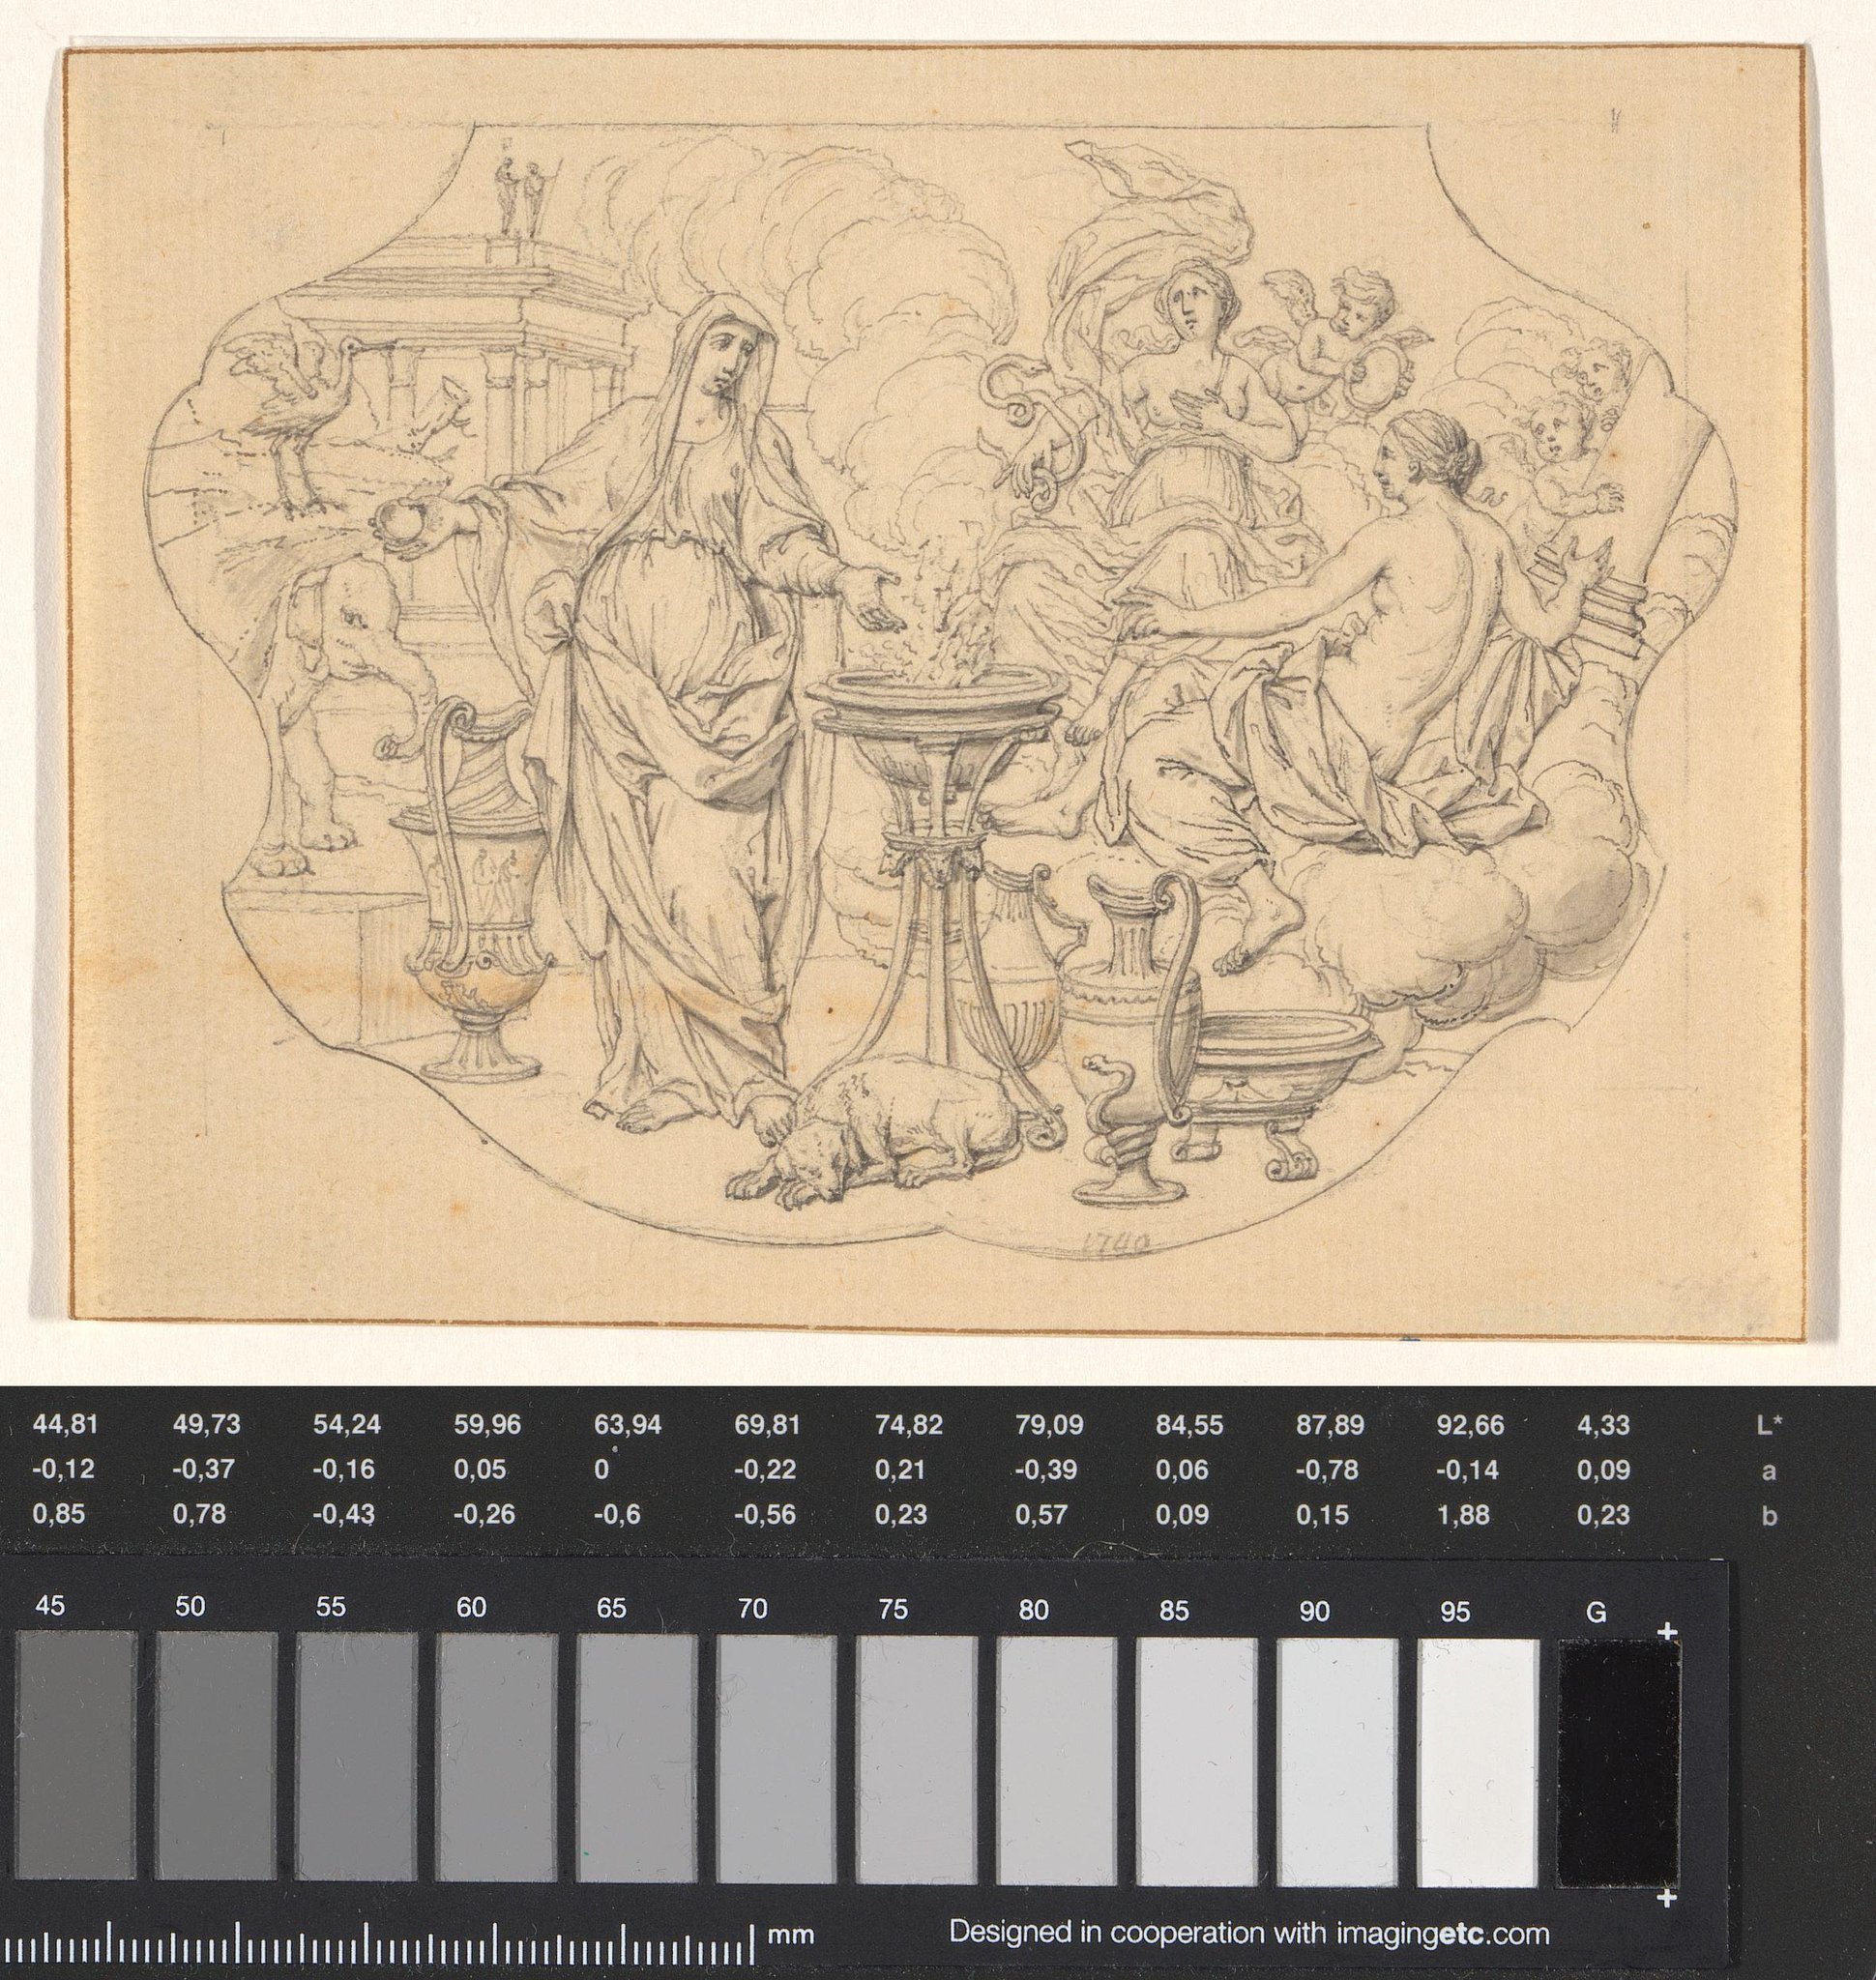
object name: drawing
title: Offertafereel, ontwerp voor het deksel van een tabaks- of snuifdoos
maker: louis fabritius dubourg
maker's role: draughtsman, print maker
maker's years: 1693-1775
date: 1740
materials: ink, pencil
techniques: brush, pen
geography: amsterdam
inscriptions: date: ‘1740’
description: Hoort bij een groep ontwerptekeningen door Dubourg. Zie RP-T-1983-335 t/m 364.